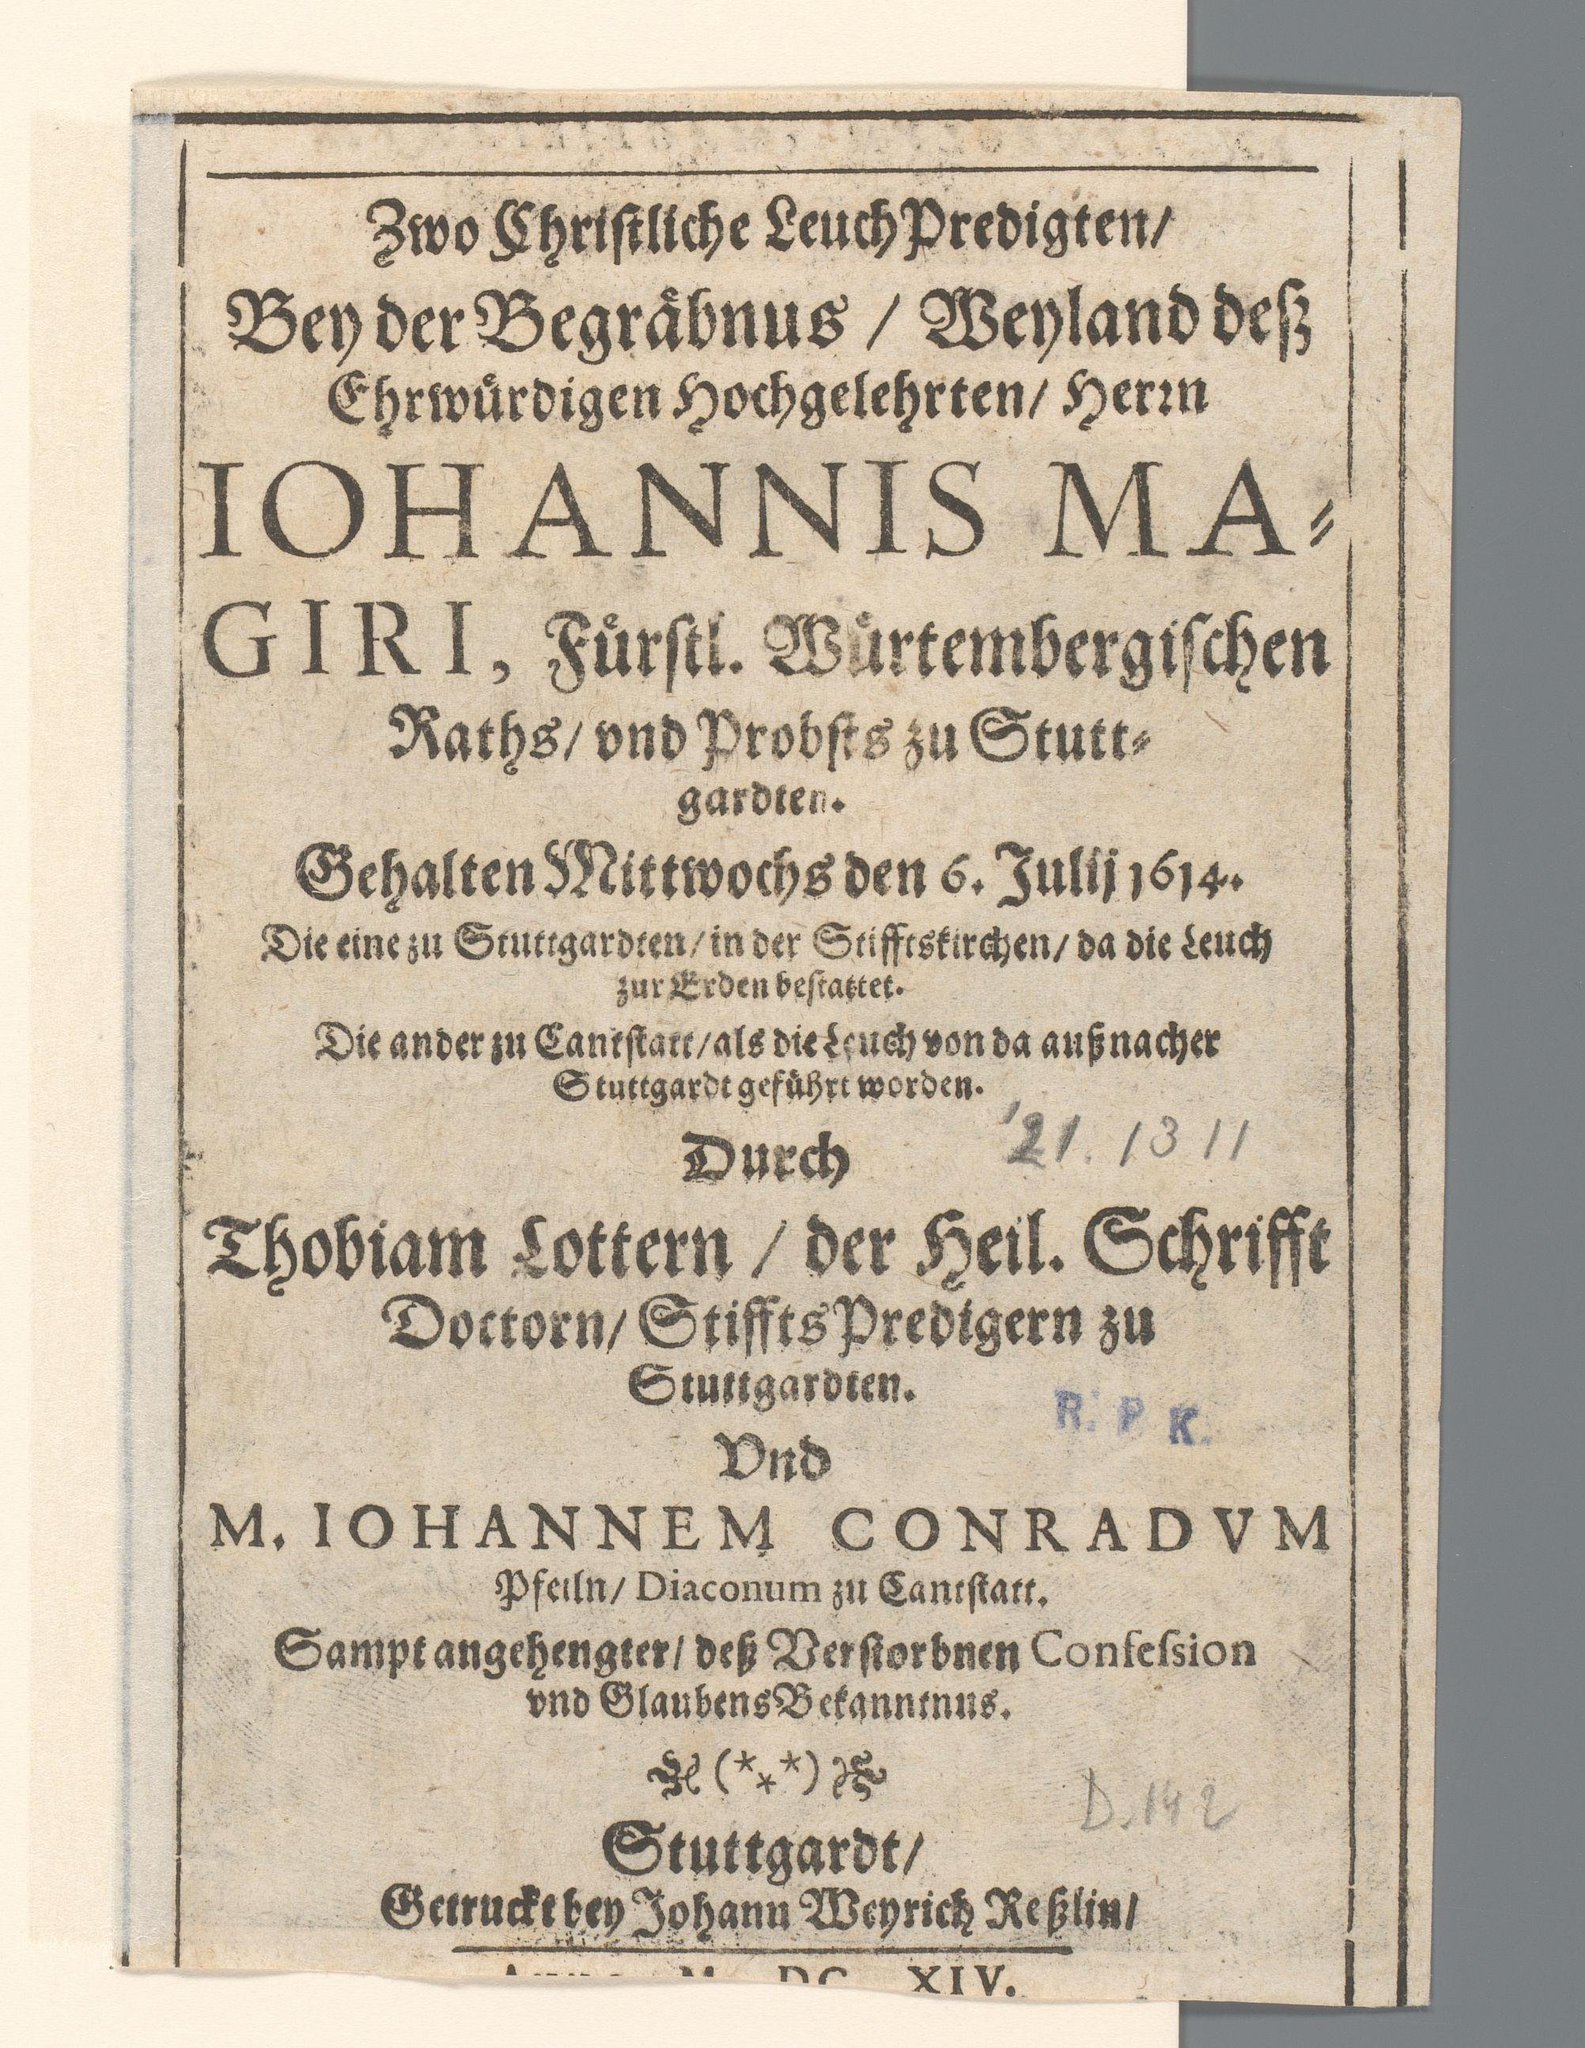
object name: titelblad, titelpagina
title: Titelpagina voor: Johannis Magiri, Fürstl. Würtembergischen (...), 1614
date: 1614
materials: paper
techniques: engraving, letterpress printing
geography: stuttgart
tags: historical persons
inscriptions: collector's mark: Lugt 2233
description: Titelpagina voor: Johannis Magiri, Fürstl. Würtembergischen (...). Stuttgart: Johann Weyrich Rösslin, 1614.